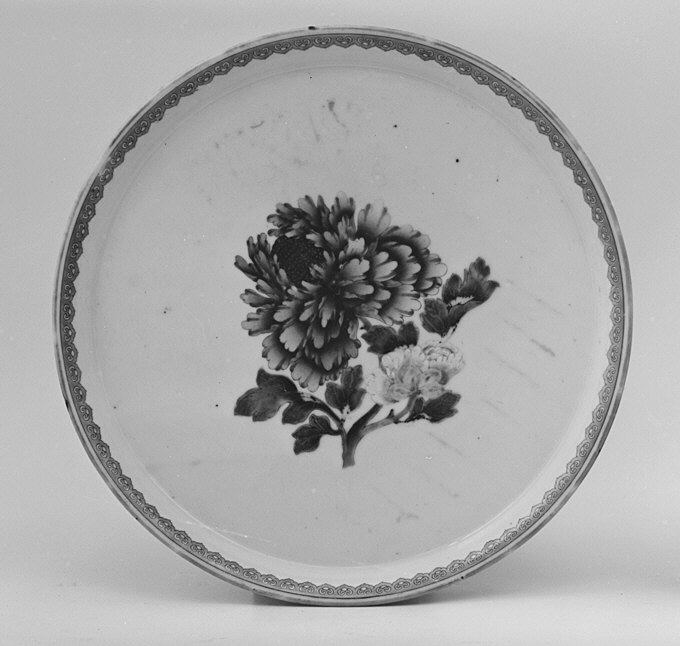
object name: stand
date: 1770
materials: hard paste porcelain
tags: flowers